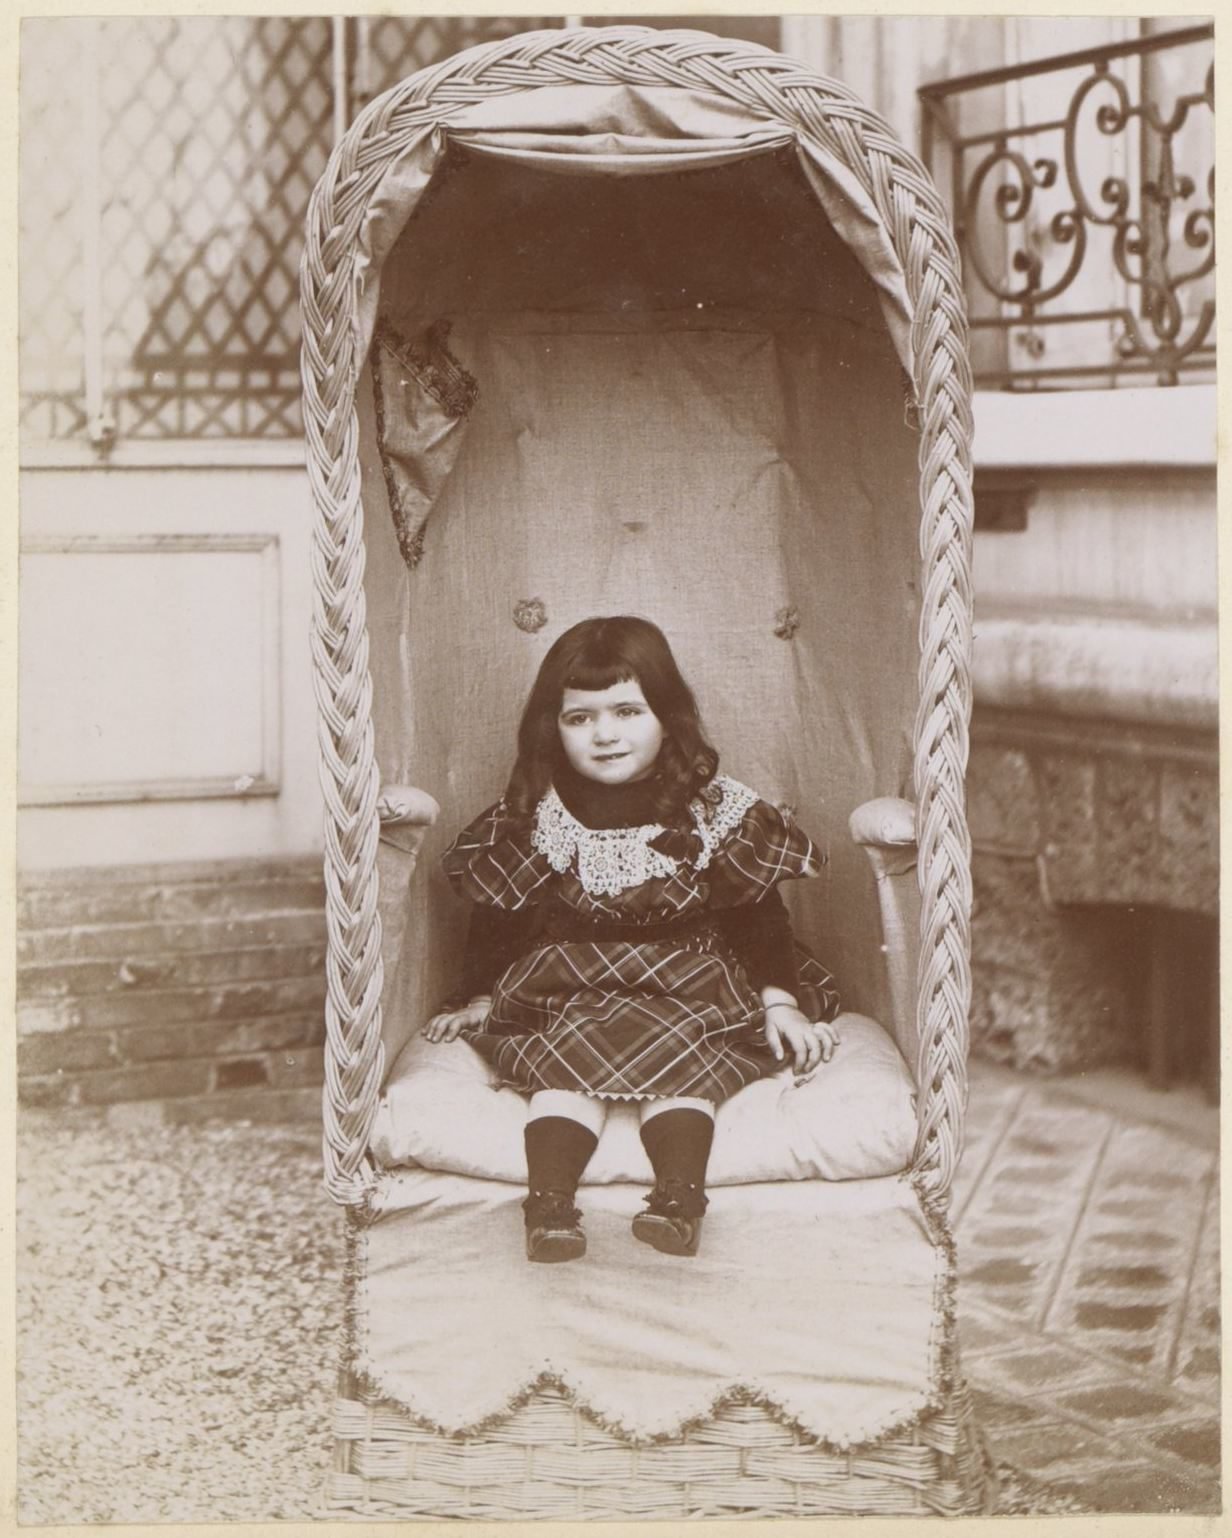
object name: photograph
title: Portret van een Franse kind in een geruite jurk, zittend in een strandstoel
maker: Anonymous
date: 1900-1910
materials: paper, photographic support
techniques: daylight paper print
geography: france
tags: child, dress, gown, chair, france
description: Onderdeel van Fotoalbum van een Franse amateurfotograaf met opnames van een familie, distilleerderij Delizy & Doistau Fils, het leger en bezienswaardigheden in Frankrijk.